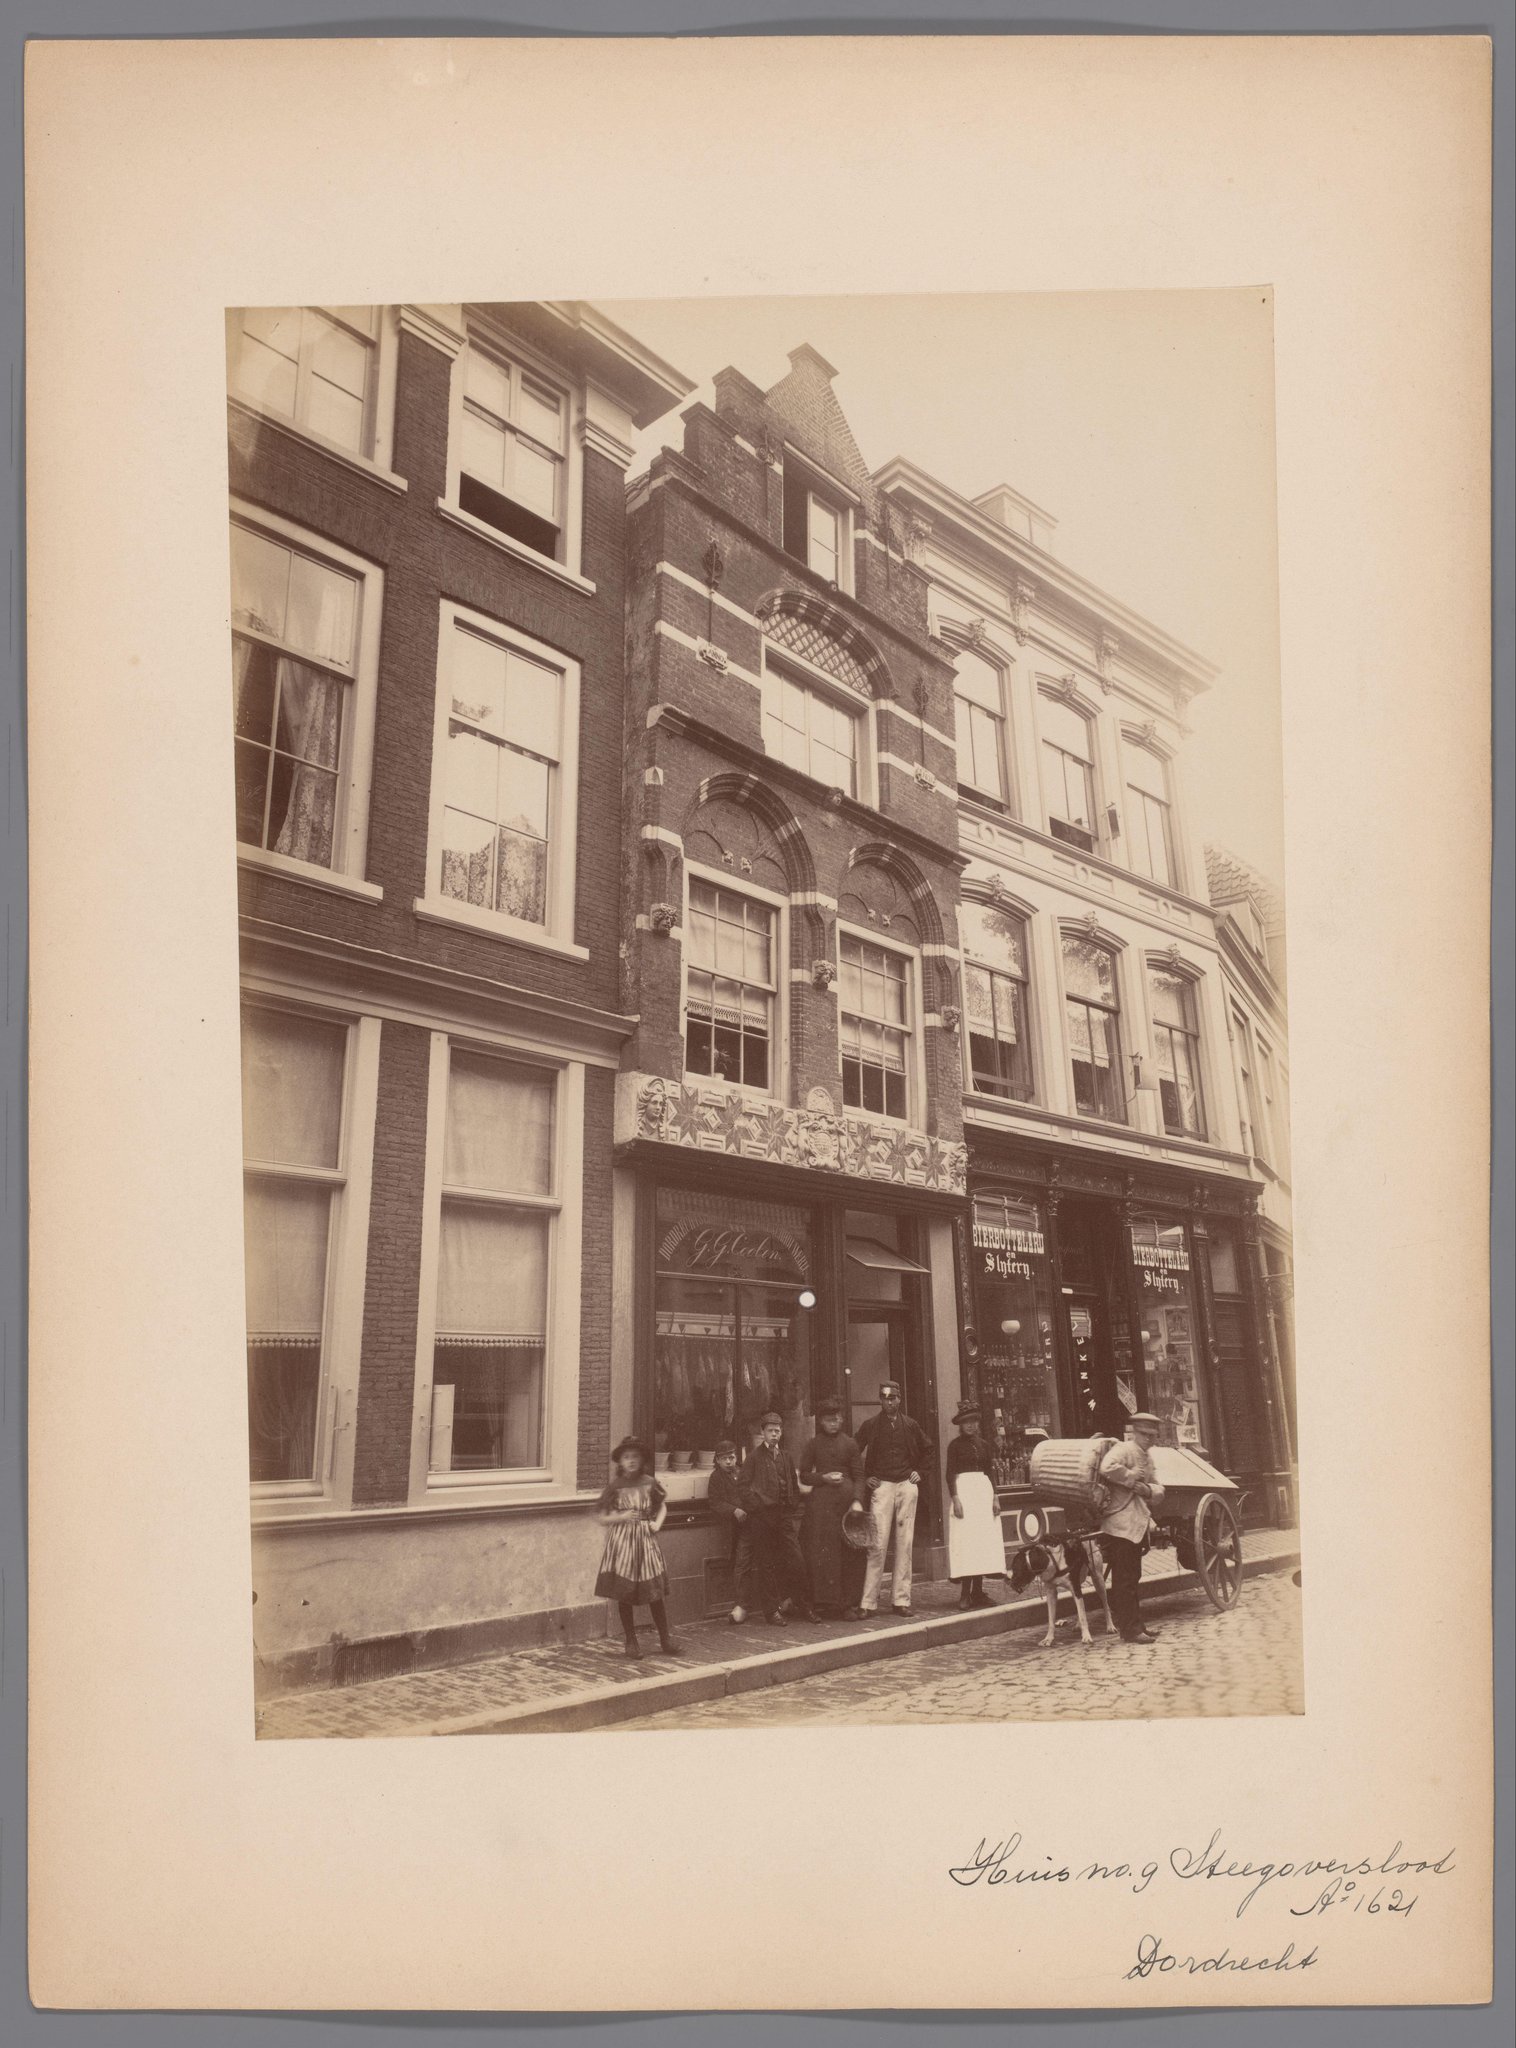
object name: photograph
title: Façade van de Steegoversloot 9 te Dordrecht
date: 1890-1910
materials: cardboard, photographic support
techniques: albumen print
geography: steegoversloot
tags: urban housing, façade (of house or building)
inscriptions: annotation: ‘Dordrecht/ Huis No 9 steegoversloot/ Anno 1621’, annotation: ‘1 [...]’, annotation: ‘Huis no. 9 Steegoversloot/ Anno 1621/ Dordrecht’